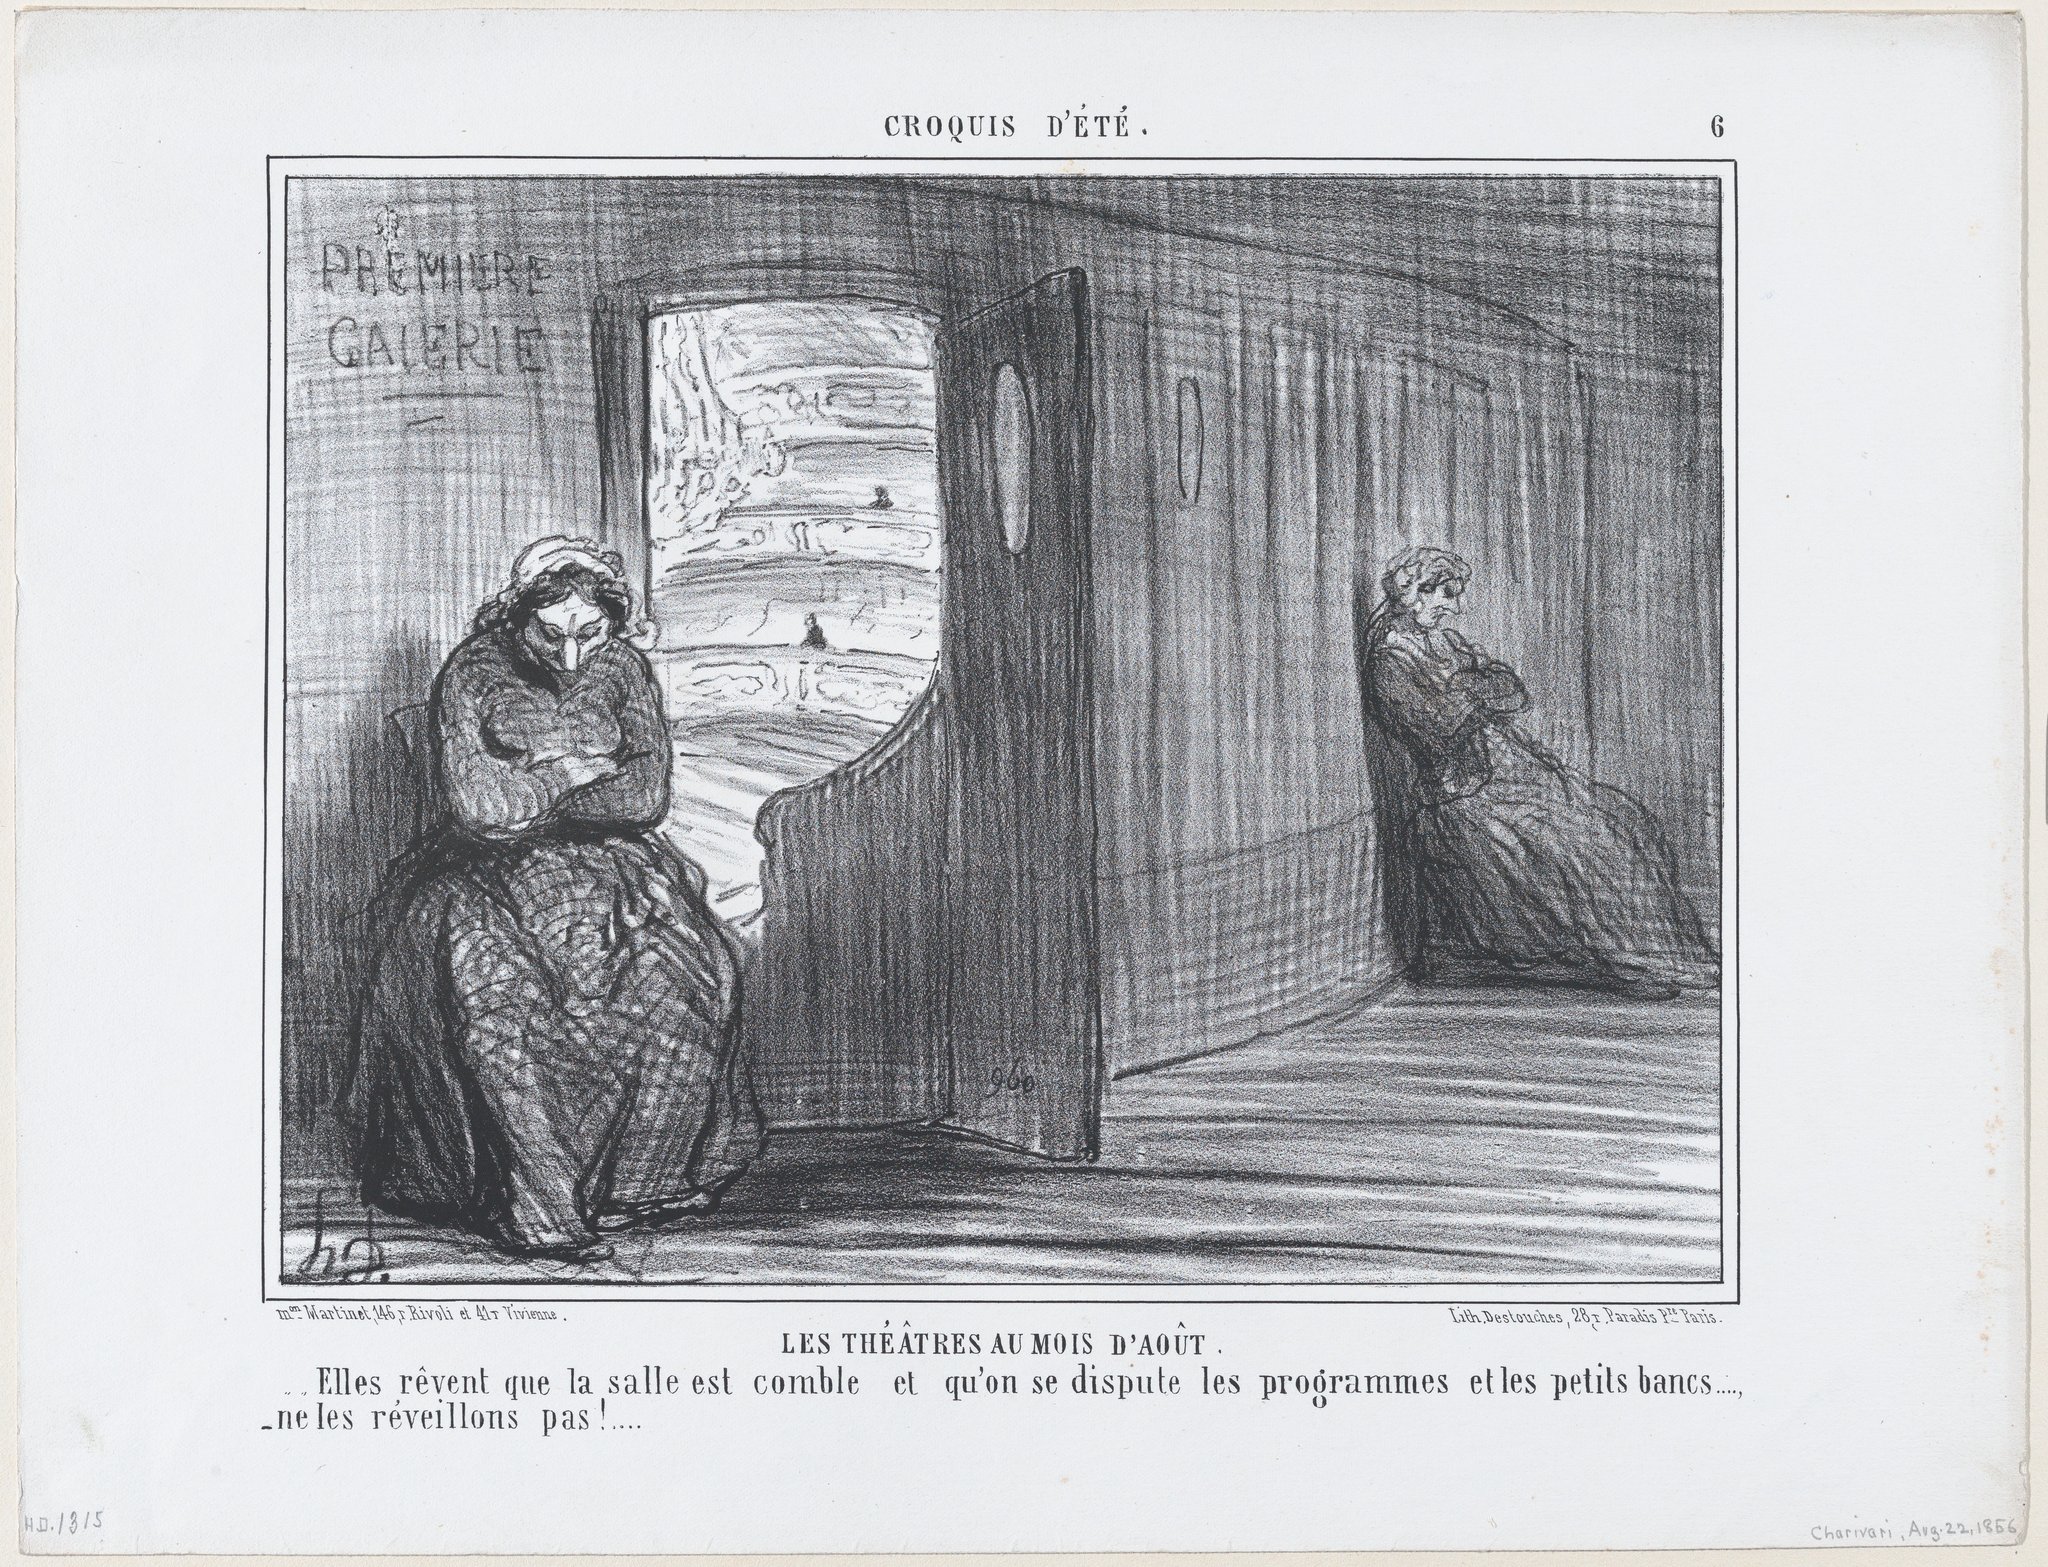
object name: print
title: Les Théâtres au Mois d'Août, from Croquis d'Été, published in Le Charivari, August 21, 1856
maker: honoré daumier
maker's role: artist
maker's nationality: french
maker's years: 1808-1879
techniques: lithograph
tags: women